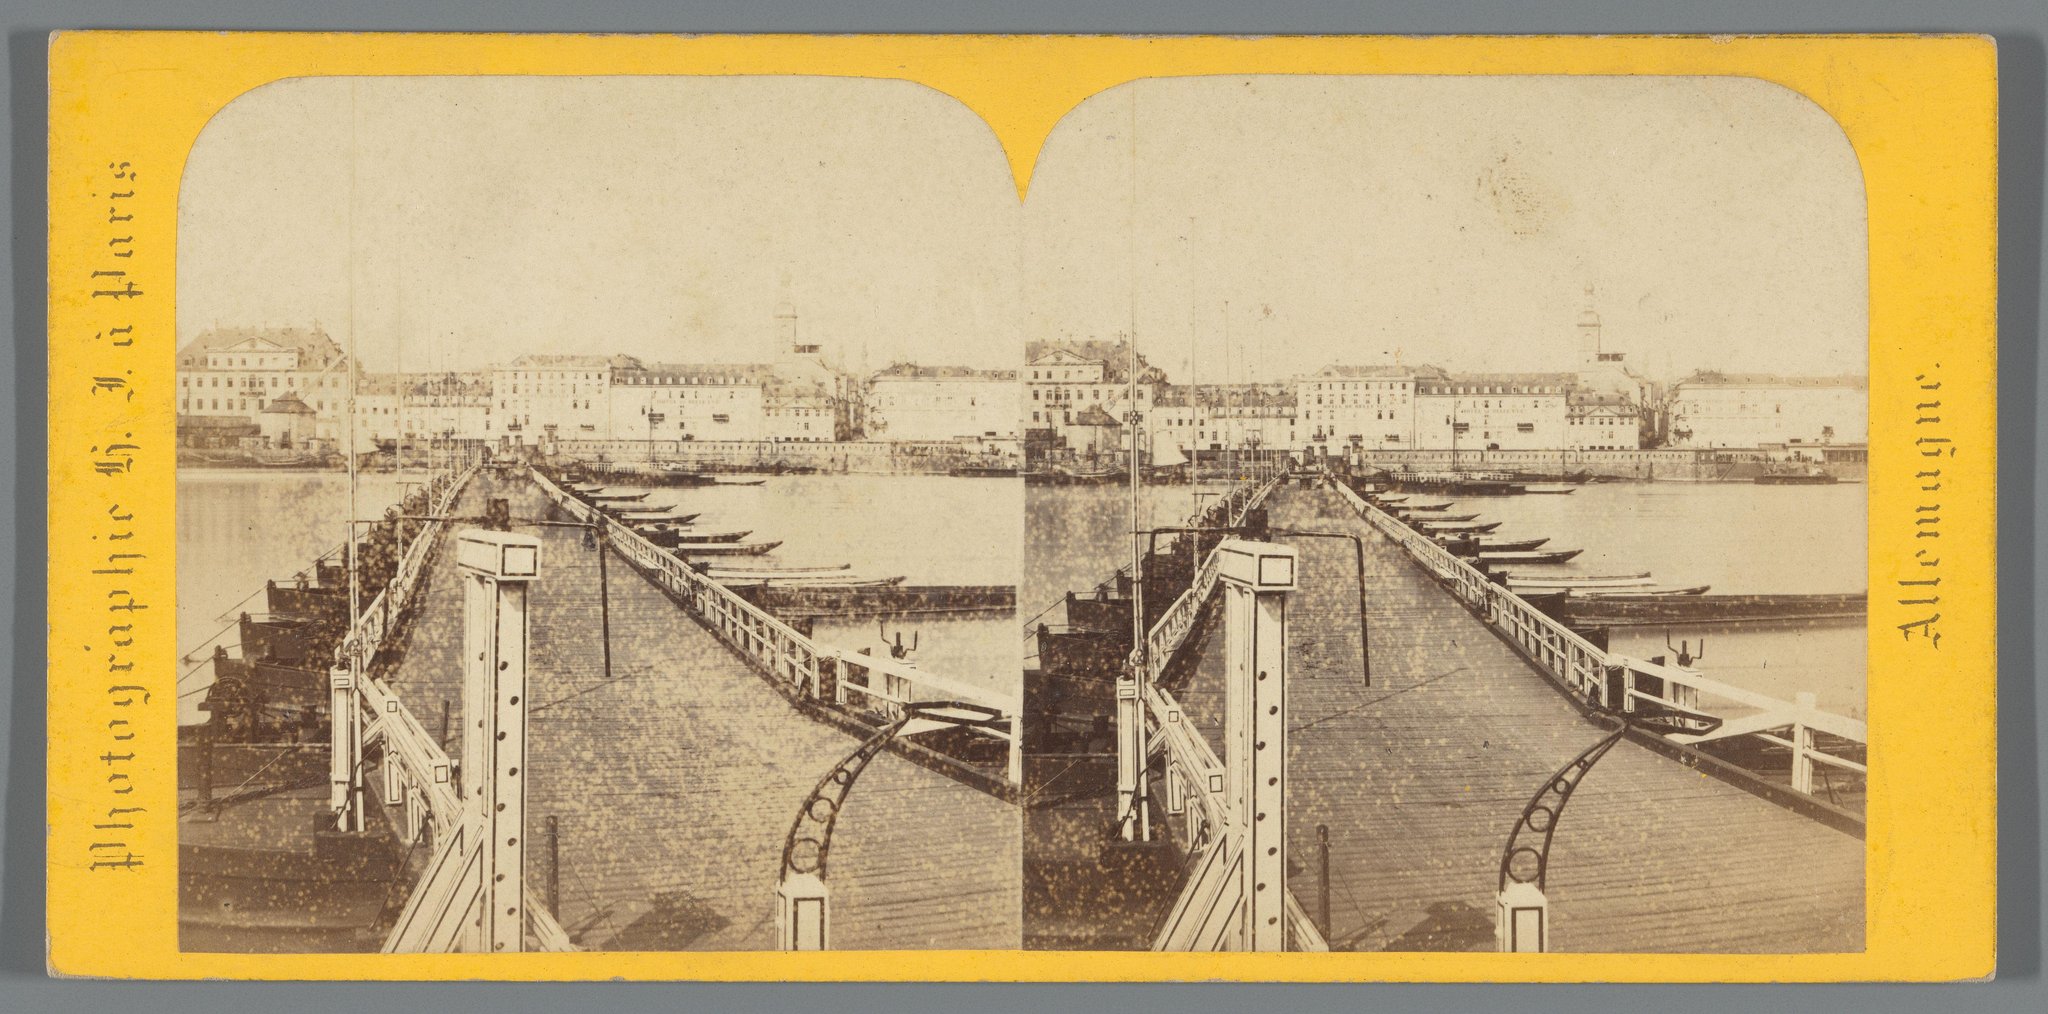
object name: stereograph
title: Allemagne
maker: hippolyte jouvin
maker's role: fotograaf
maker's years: 1825-1889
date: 1861-1870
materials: cardboard, paper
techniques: albumen print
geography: koblenz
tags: city-view in general; 'veduta'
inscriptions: number: ‘N. 513’, inscription: ‘Déposé.’